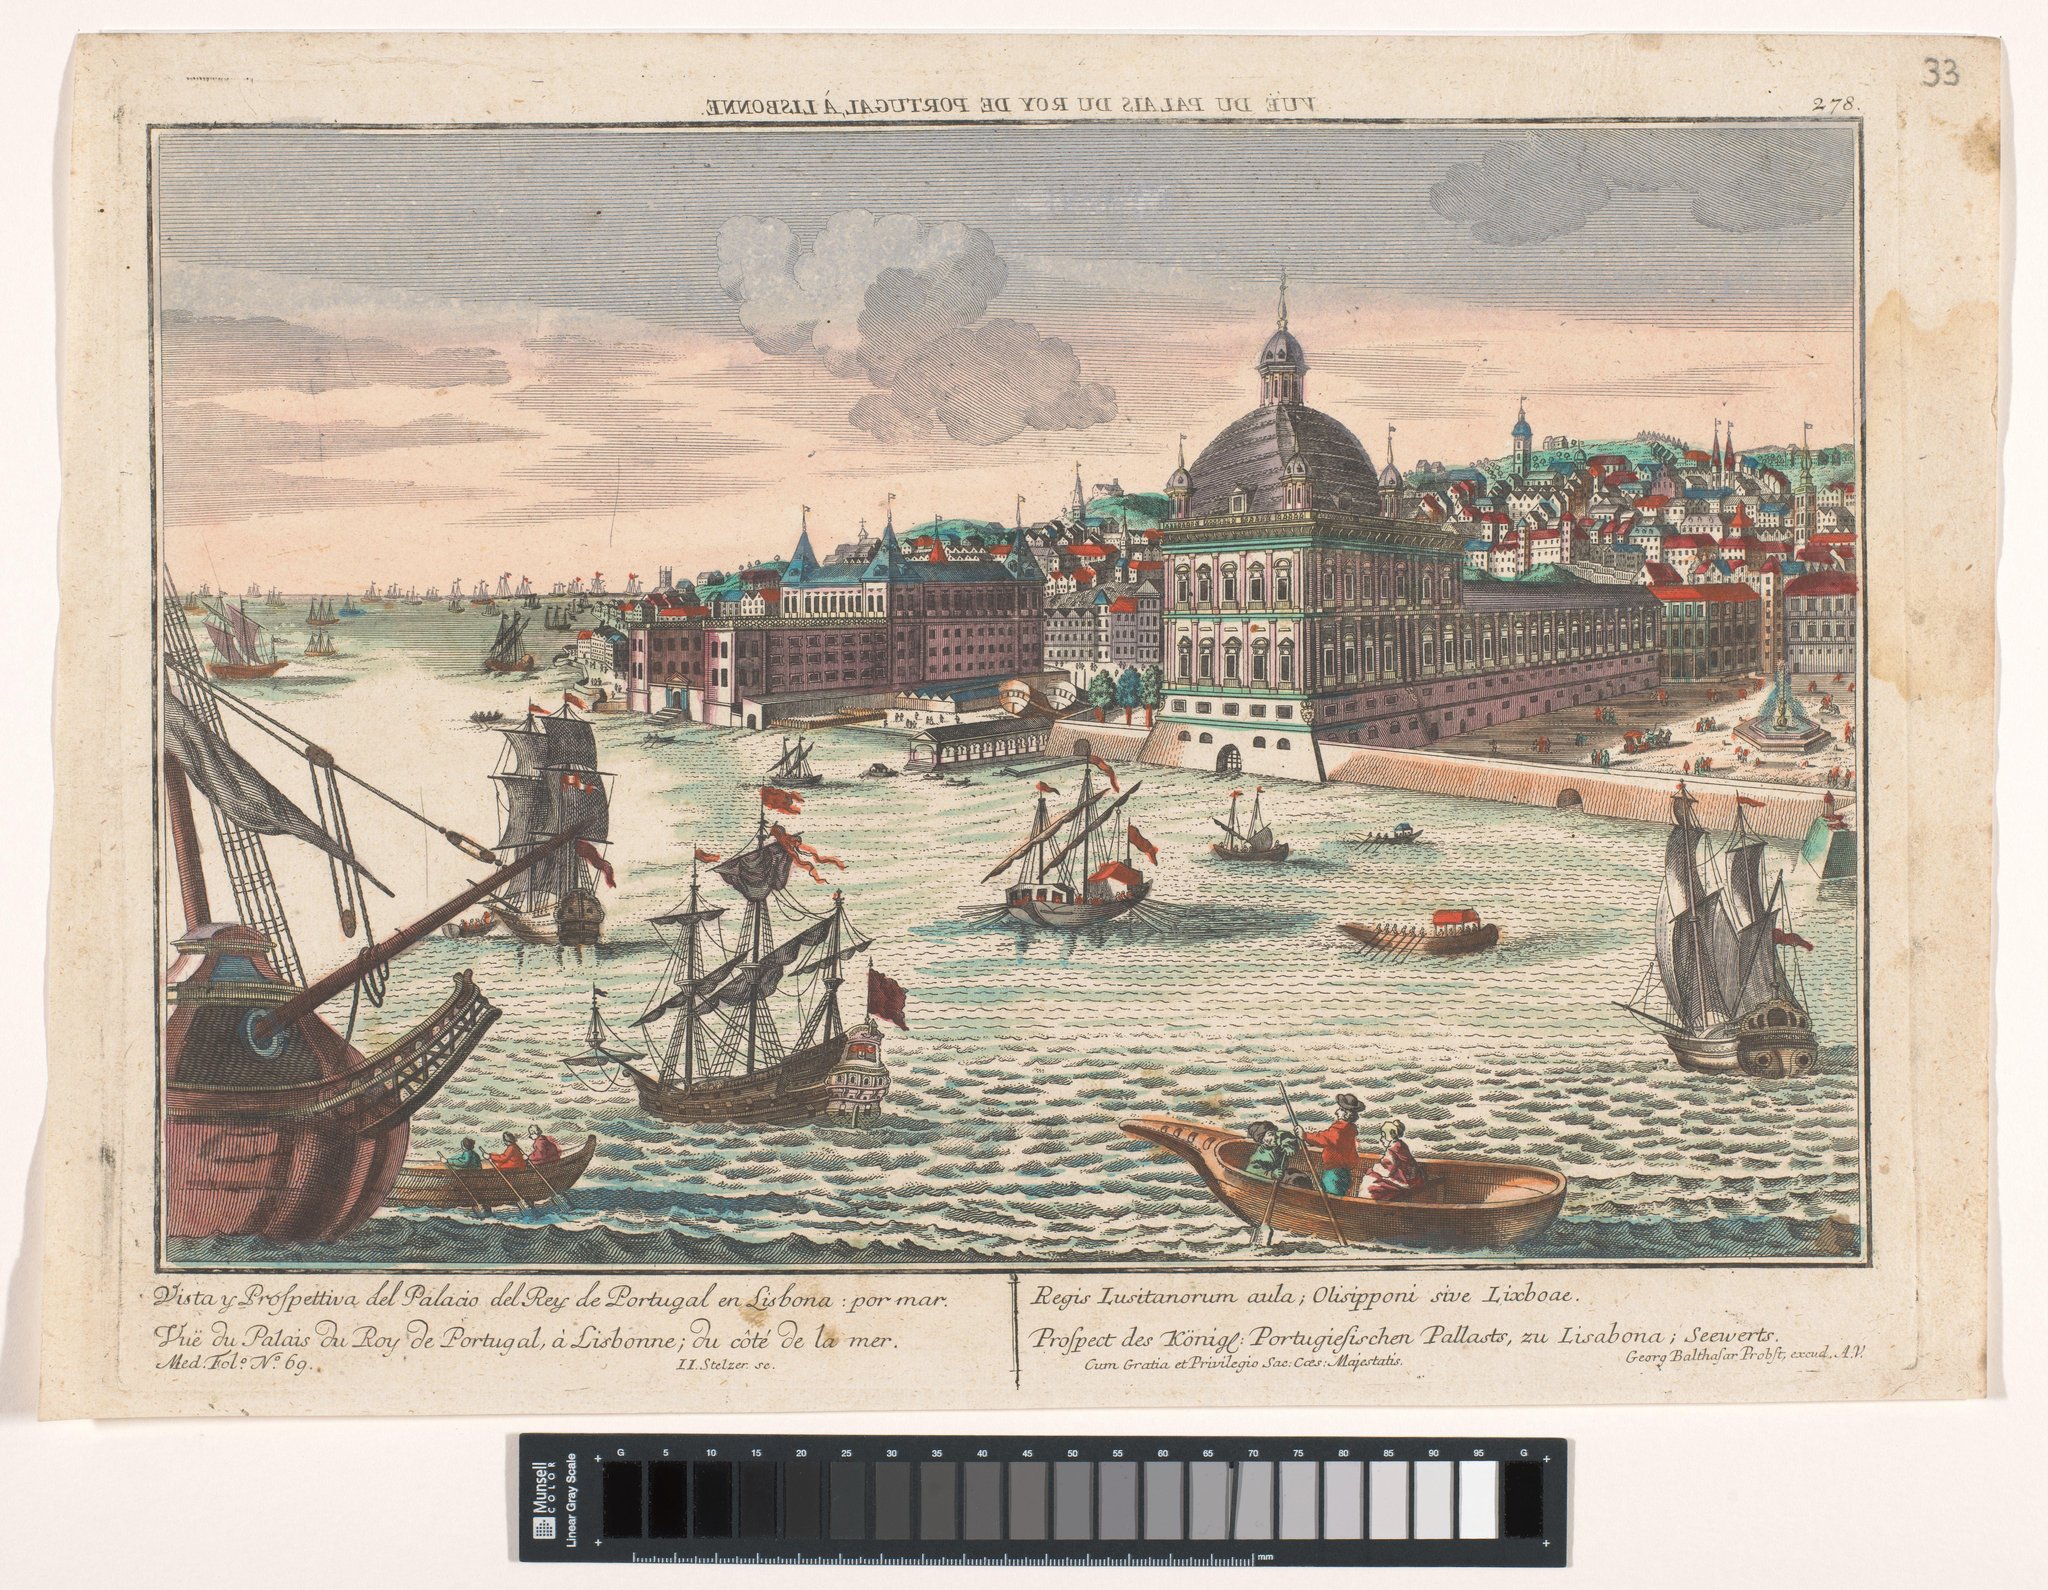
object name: opticaprent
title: Gezicht op het Koninklijk Paleis te Lissabon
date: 1742-1801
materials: paper, watercolor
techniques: brush, etching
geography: germany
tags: sailing-ship, sailing-boat, palace, rowing-boat, canoe, etc., sea (seascape) (+ landscape with figures, staffage), square, place, circus, etc. (+ city(-scape) with figures, staffage), ornamental fountain (+ city(-scape) with figures, staffage), canals, waters (in city) (+ city(-scape) with figures, staffage)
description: Op de voorgrond de rivier de Taag. Op de achtergrond links de zee. Rechtsboven genummerd: 278. Linksonder genummerd: 69.